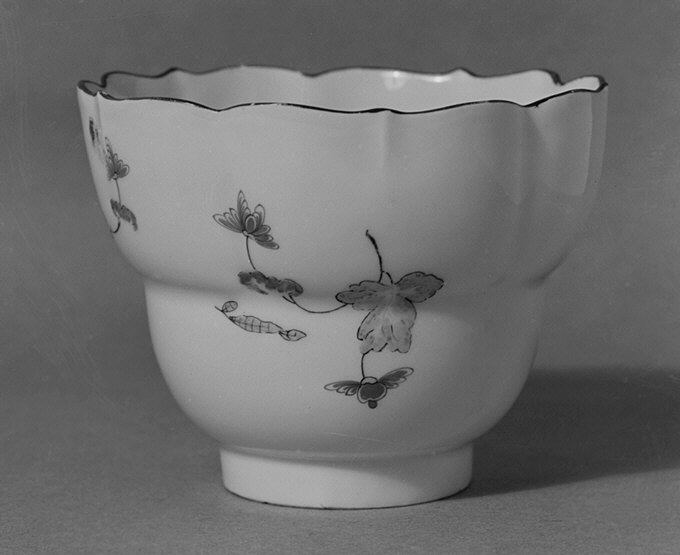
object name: cup and saucer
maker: meissen manufactory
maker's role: manufactory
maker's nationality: german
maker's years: 1710-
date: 1740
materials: hard paste porcelain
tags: birds,flowers